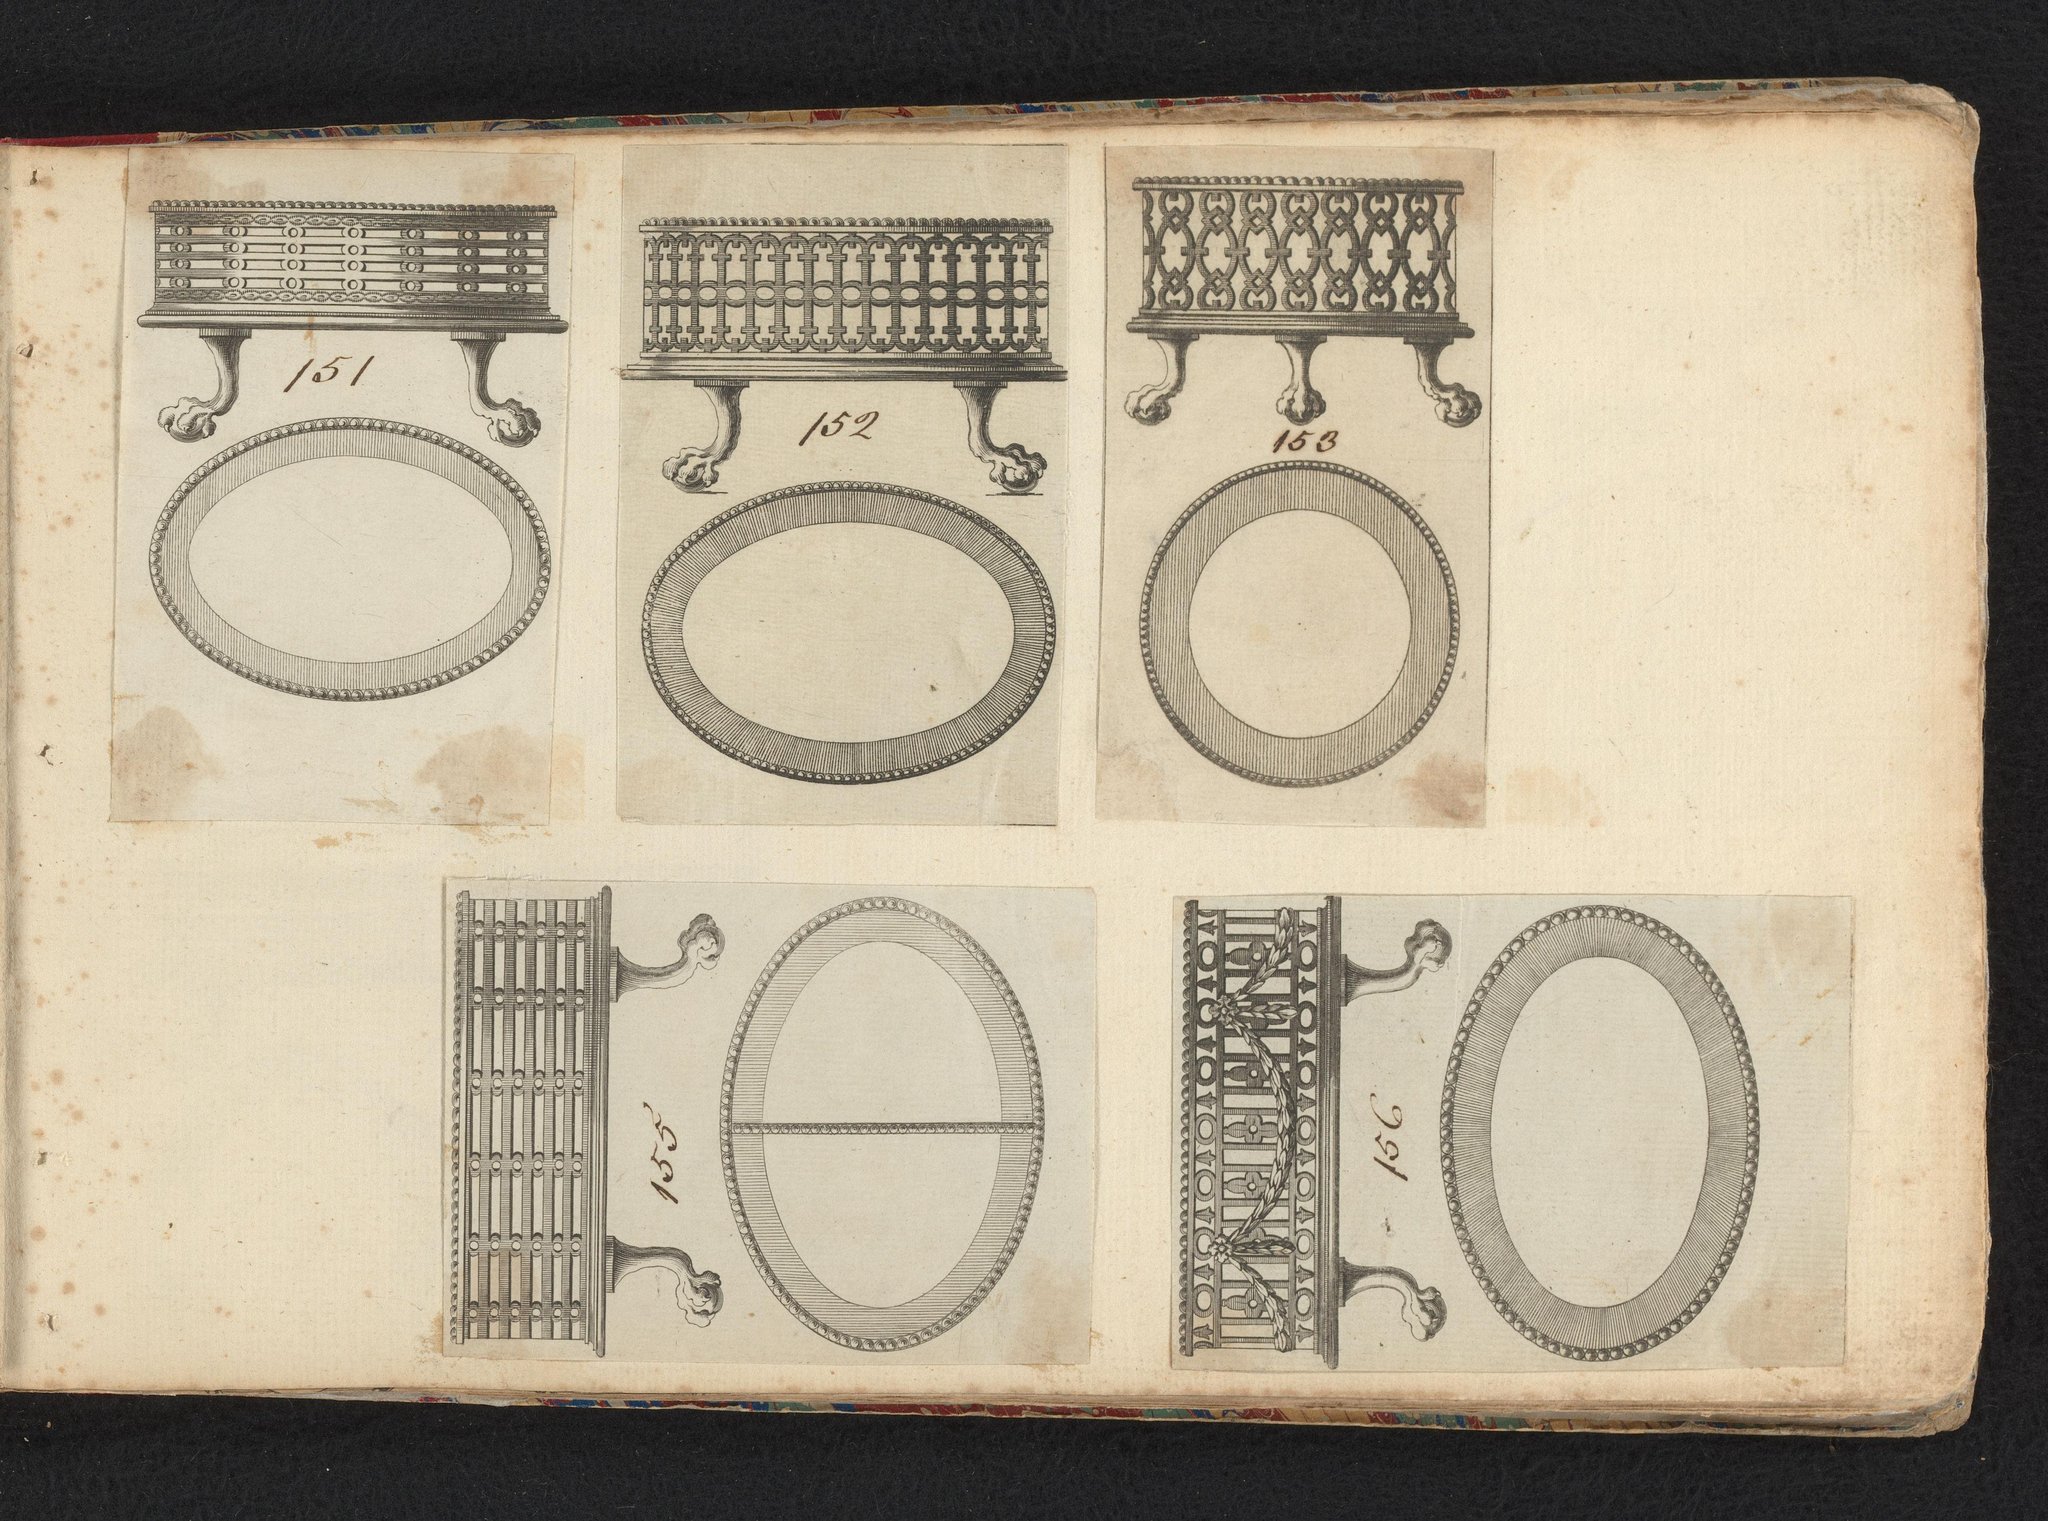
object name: print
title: Ontwerpen voor terrines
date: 1784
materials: paper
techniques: engraving, etching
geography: england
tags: serving-dish, platter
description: Blad met vijf ingeplakte bladen met ontwerpen voor terrines op poten. Met de handgeschreven nrs. 151-153 en 155-156. Onderdeel van een catalogus met assortiment modellen van Sheffield verzilverd vaatwerk (pleet) door Matthew Boulton.